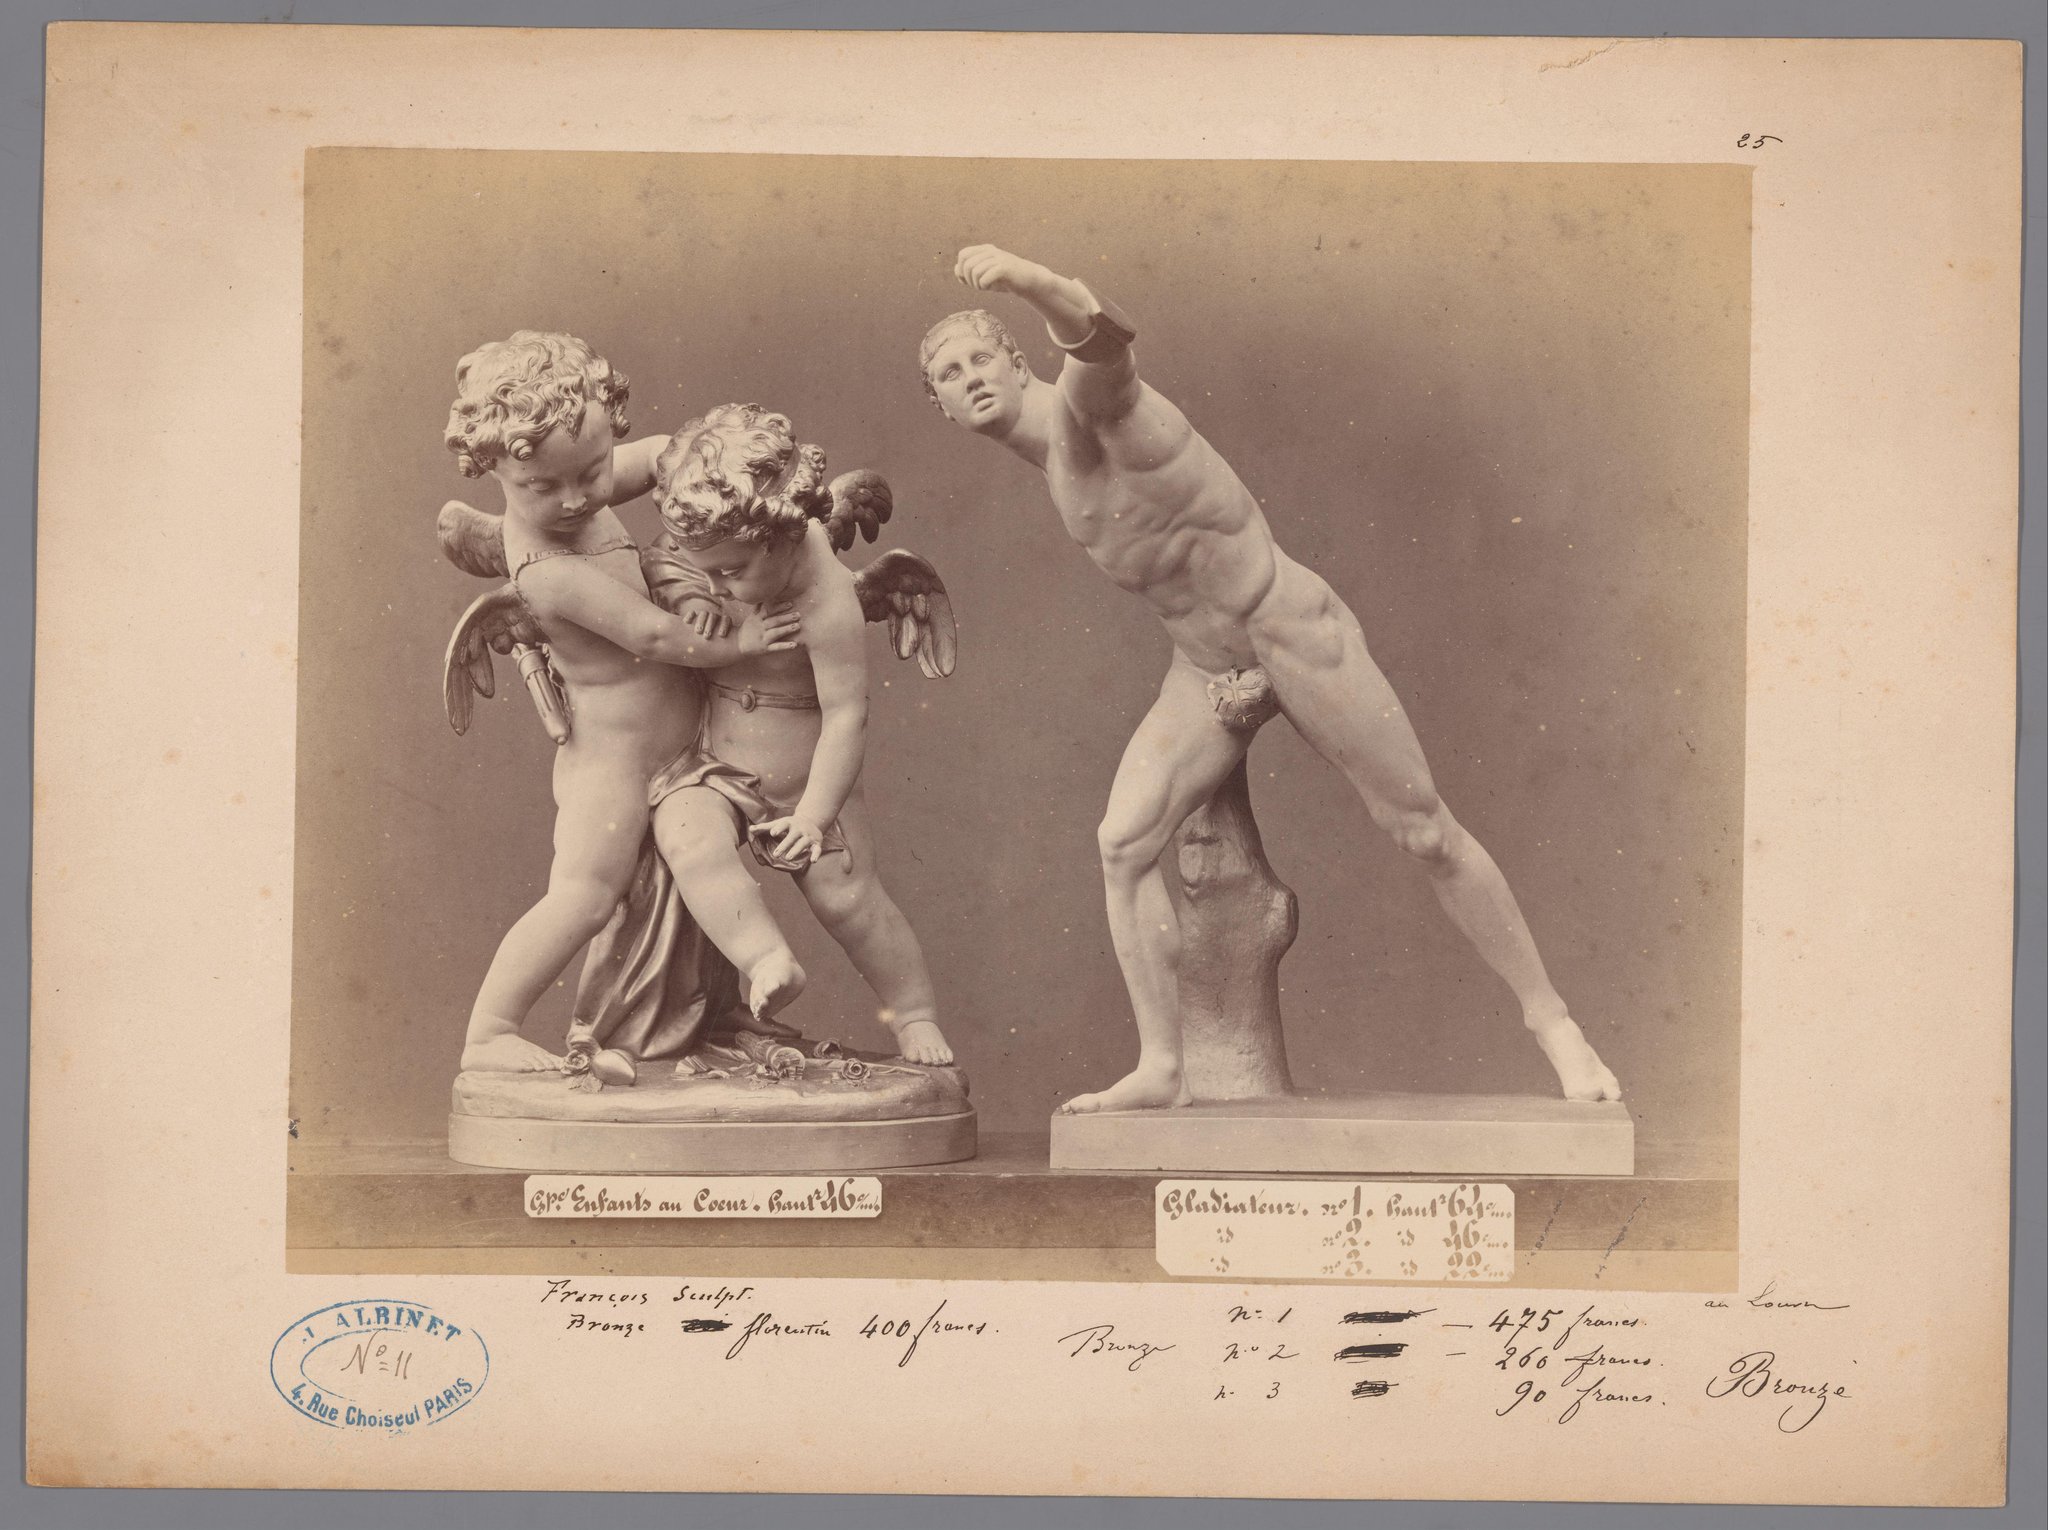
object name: photograph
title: Gezicht op twee beelden van mythologische figuren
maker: Anonymous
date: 1850-1900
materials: cardboard, photographic support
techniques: albumen print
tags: sculpture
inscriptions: inscription: ‘Francois Sculpt/ Bornze (...)’, inscription: ‘[...]/ Boasberg/ april 84’, stamp: ‘Albinet/ 4. Rue Choiseul Paris’, number: ‘No.11’, stamp: ‘AV’